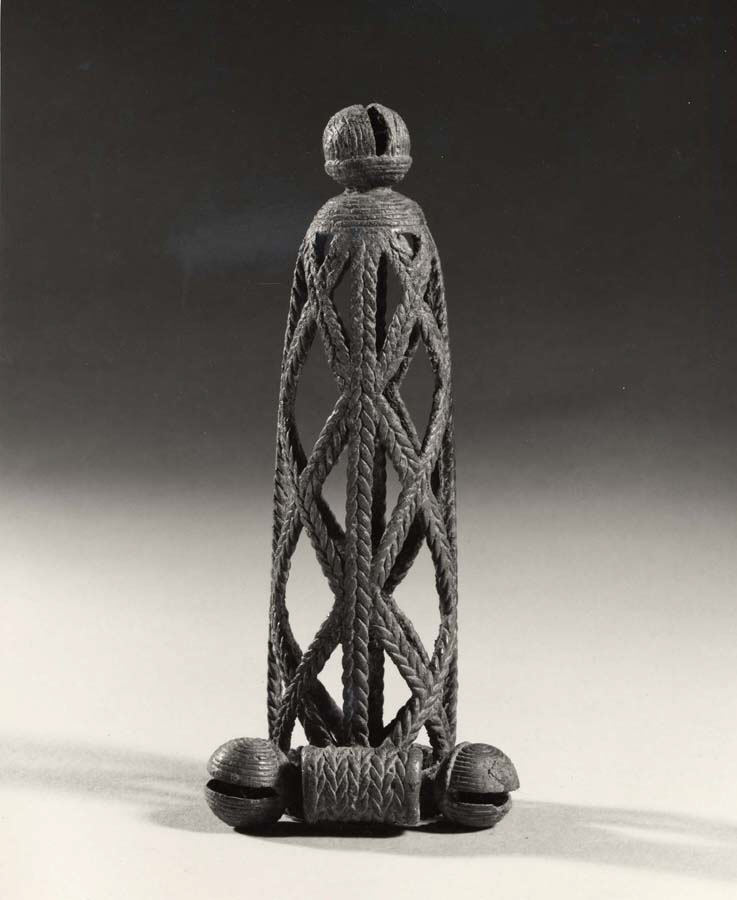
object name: baton handle or penis sheath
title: Baton Handle or Penis Sheath (?)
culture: vietnamese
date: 1-300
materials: bronze